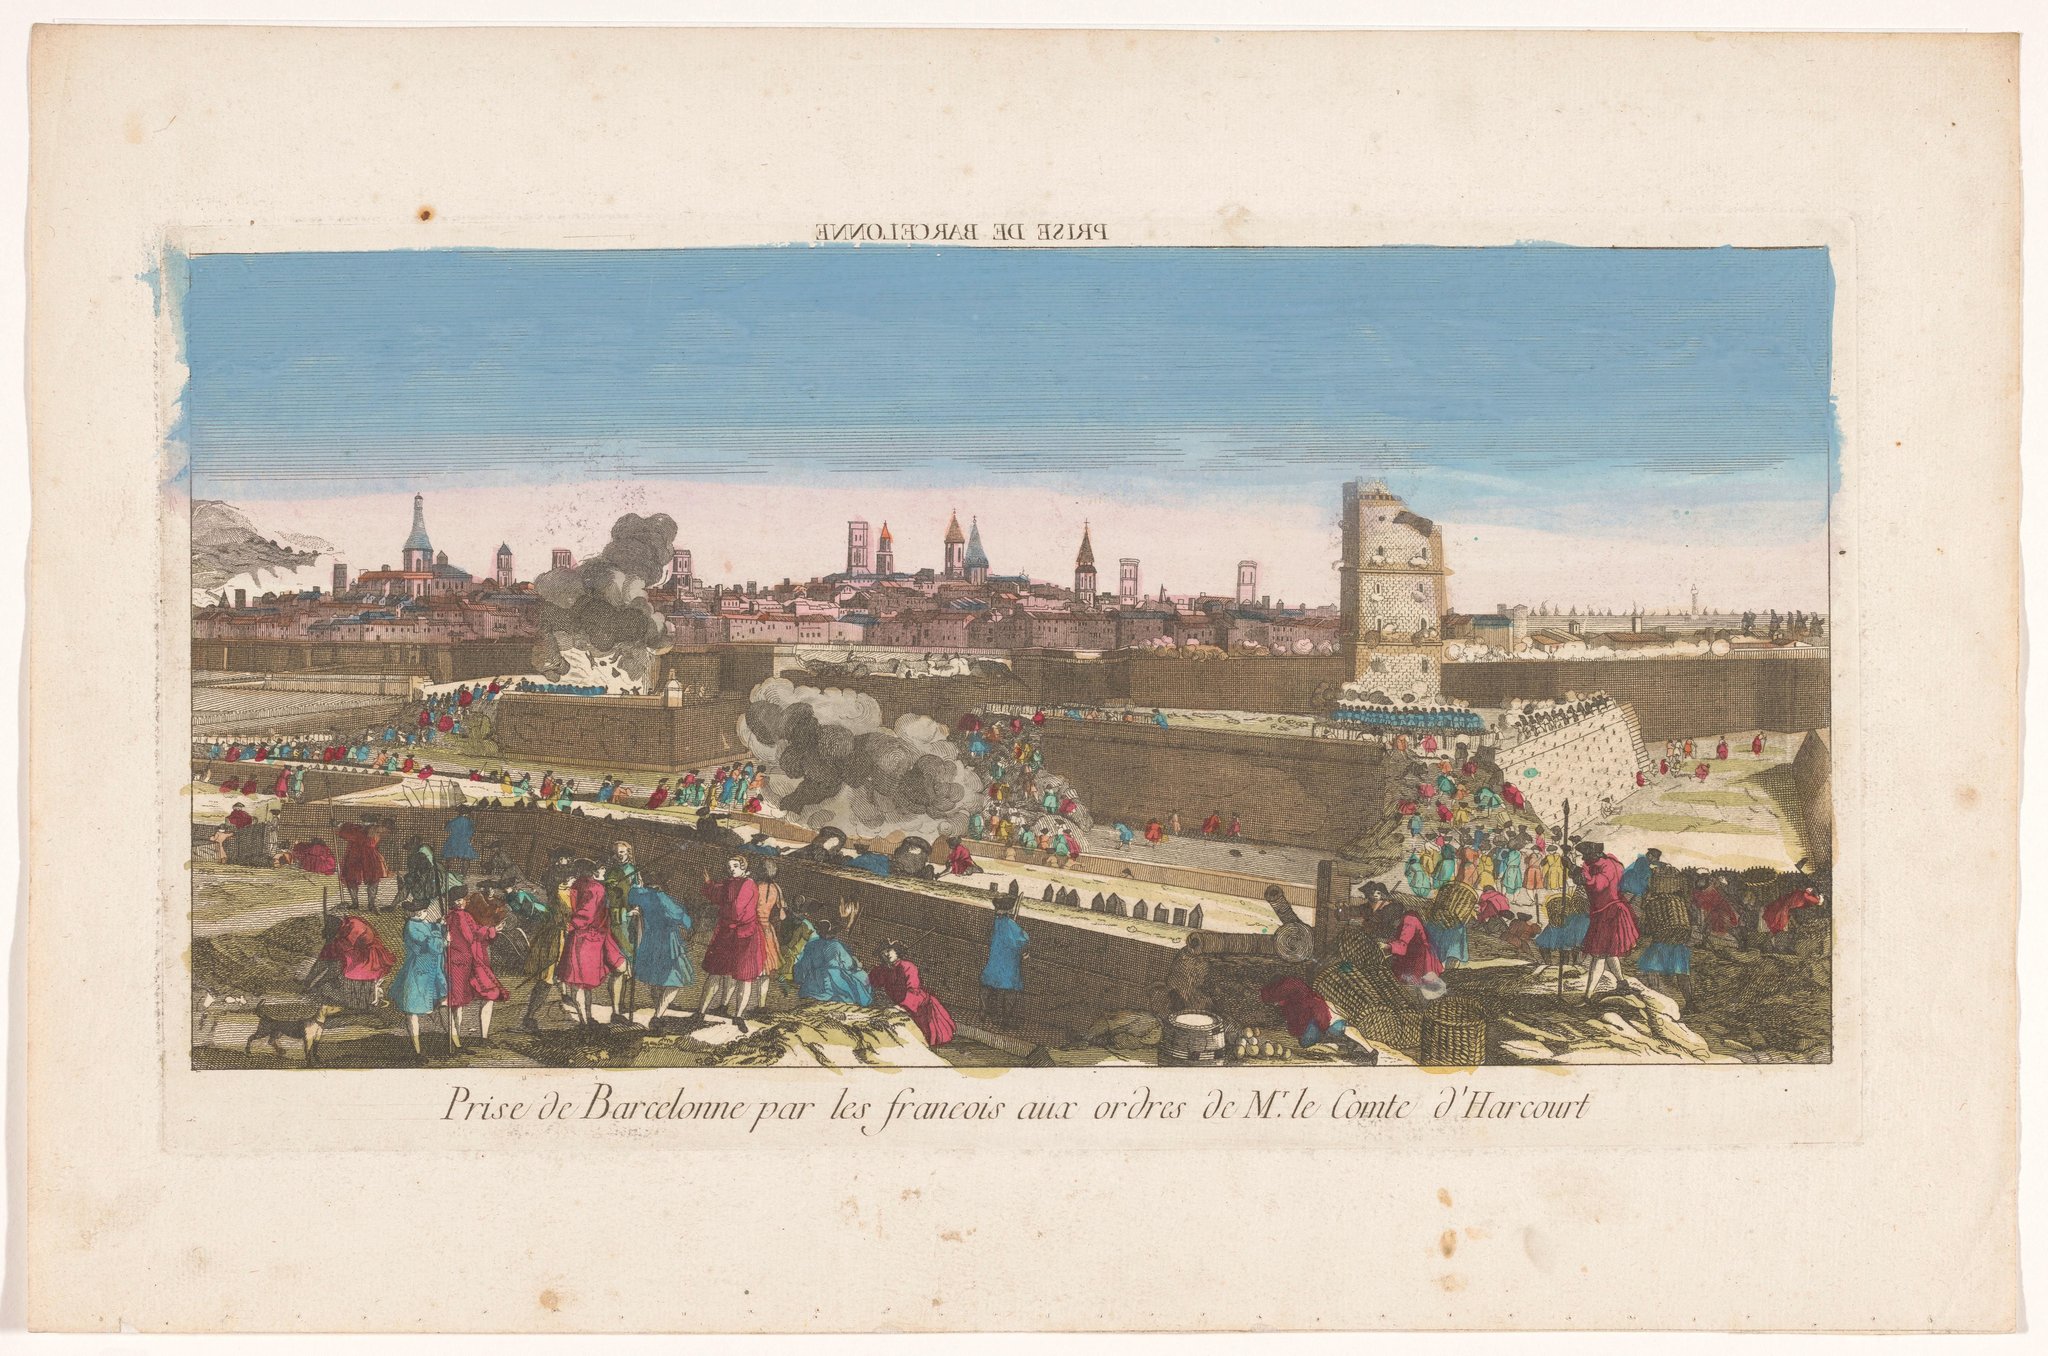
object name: opticaprent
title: Prise de Barcelonne par les Francois aux ordres de mr. le comte d'Harcourt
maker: Anonymous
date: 1700-1799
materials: paper, watercolor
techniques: brush, etching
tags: attack ~ siege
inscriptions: watermark, collector's mark: Lugt 2166